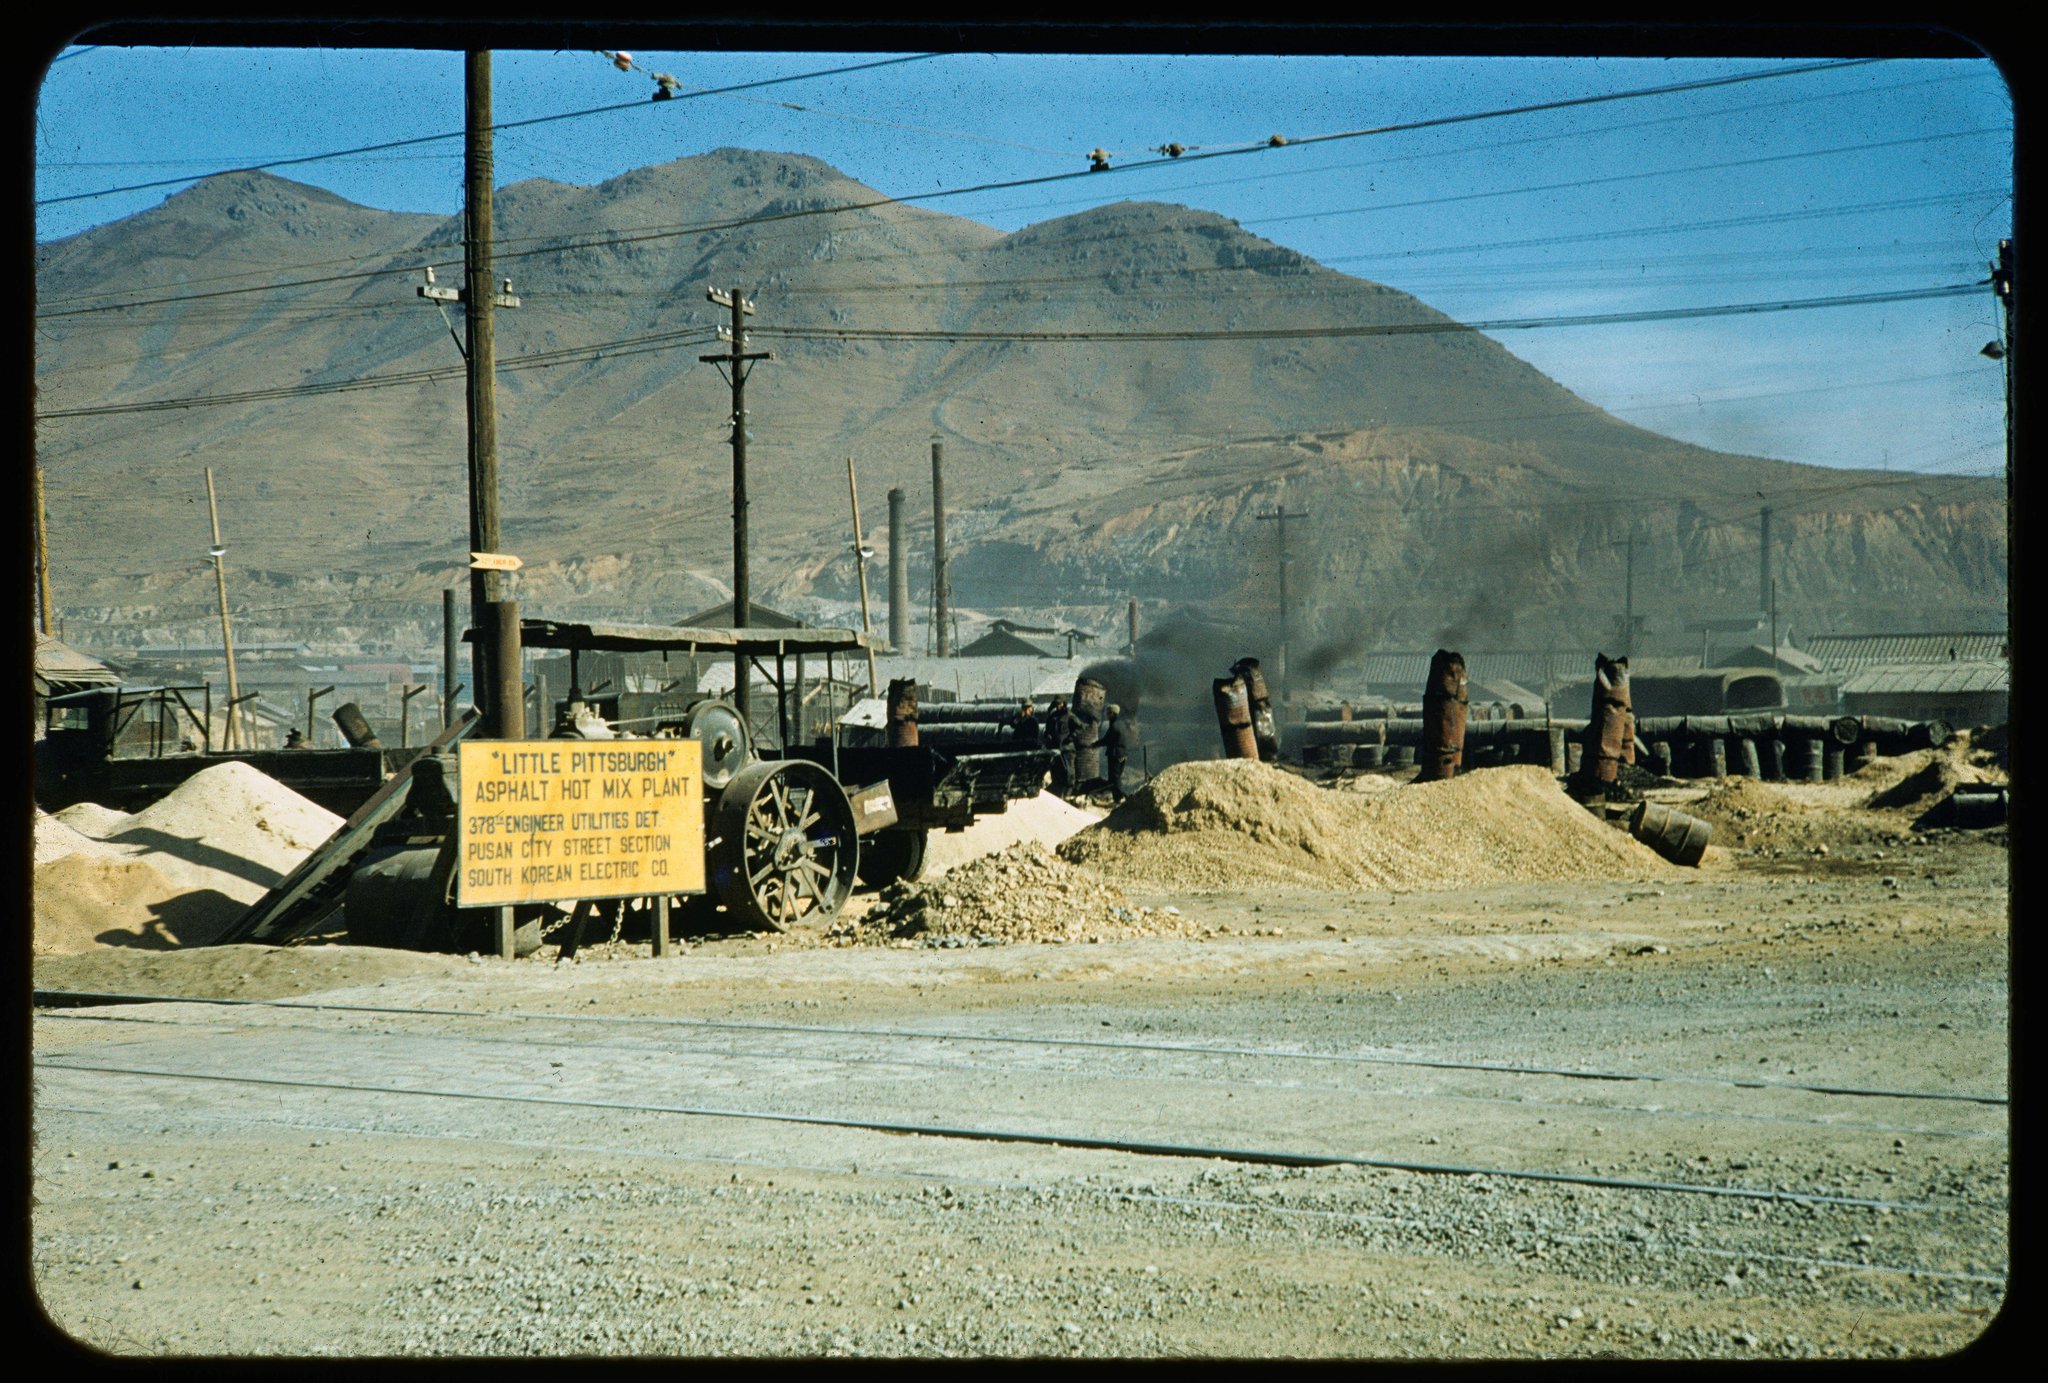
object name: color slide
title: Fabricage van asfalt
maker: david ketel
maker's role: diplomaat, sinoloog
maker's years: 1913-2008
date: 1951-1953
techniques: slide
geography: korea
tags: united nations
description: Little Pittsburgh, Asphalt Hot Mix Plant, staat op het gele bord. Fabricage van asfalt midden op de weg naar Pusan.